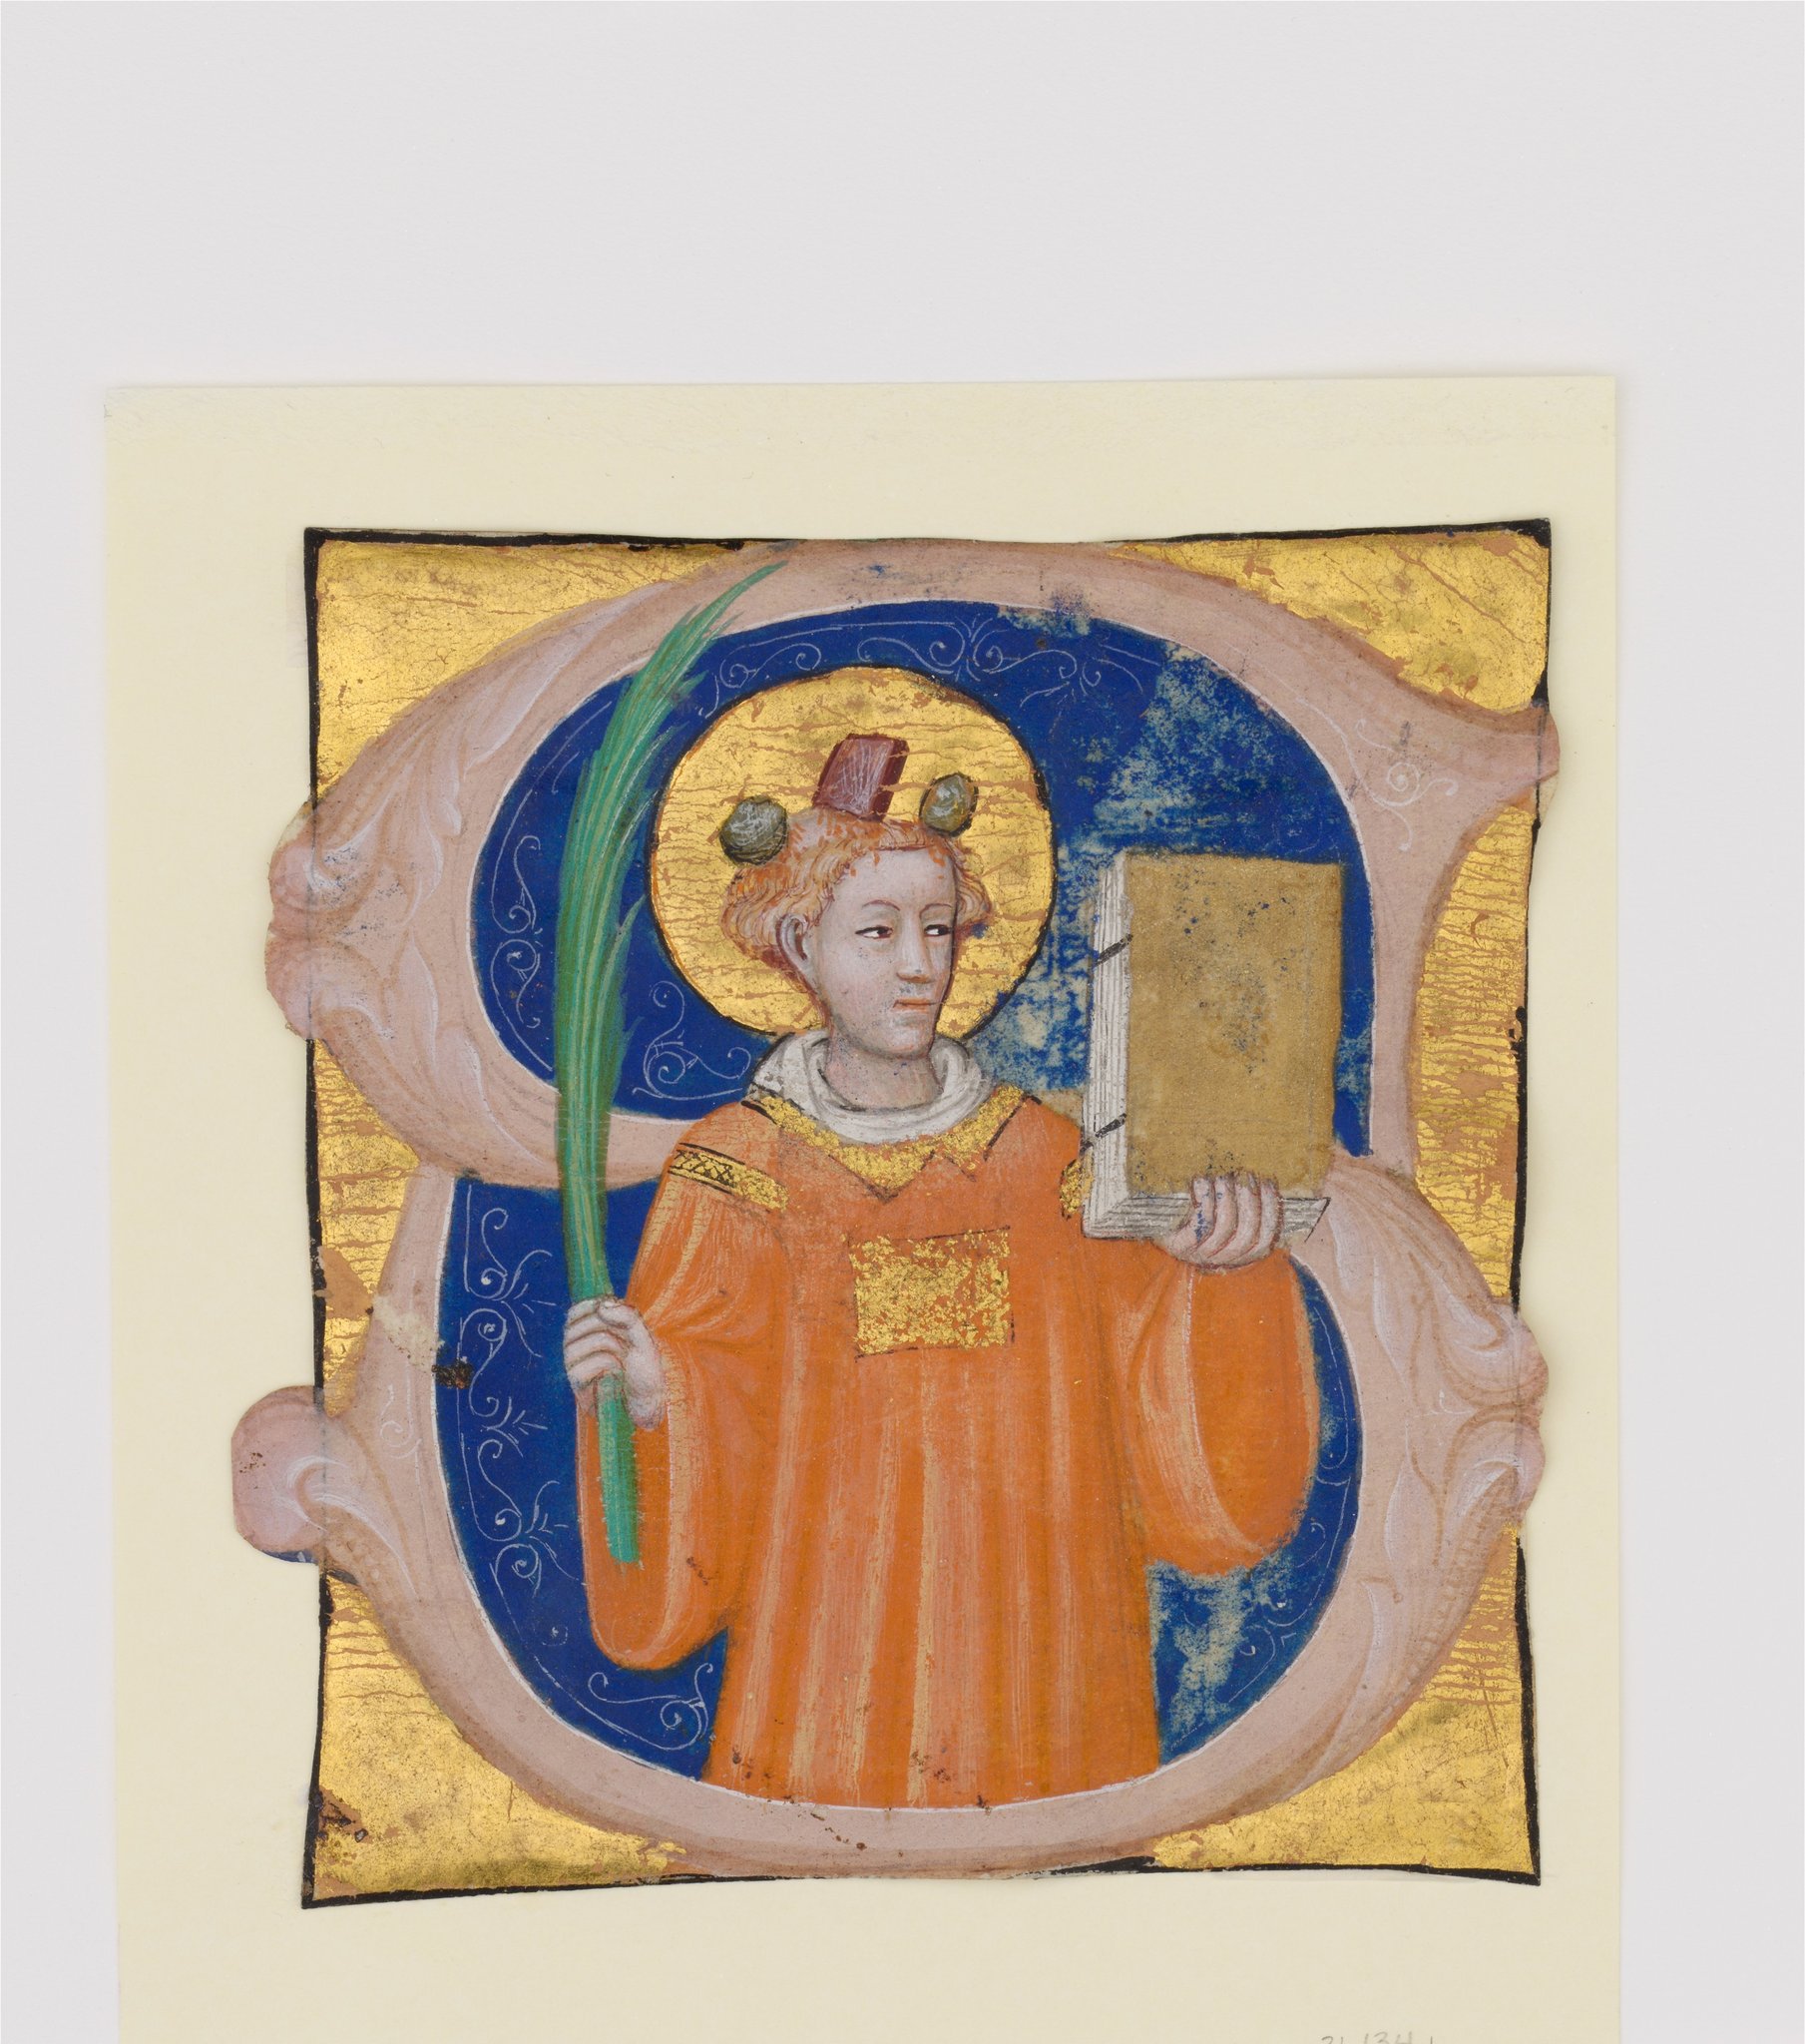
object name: antiphonary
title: Manuscript Illumination with Saint Stephen in an Initial S, from an Antiphonary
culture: italian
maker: master of the brussels initials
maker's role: artist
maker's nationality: italian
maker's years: 1390-1420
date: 1410-1420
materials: gold, ink, parchment, paint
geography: italy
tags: books